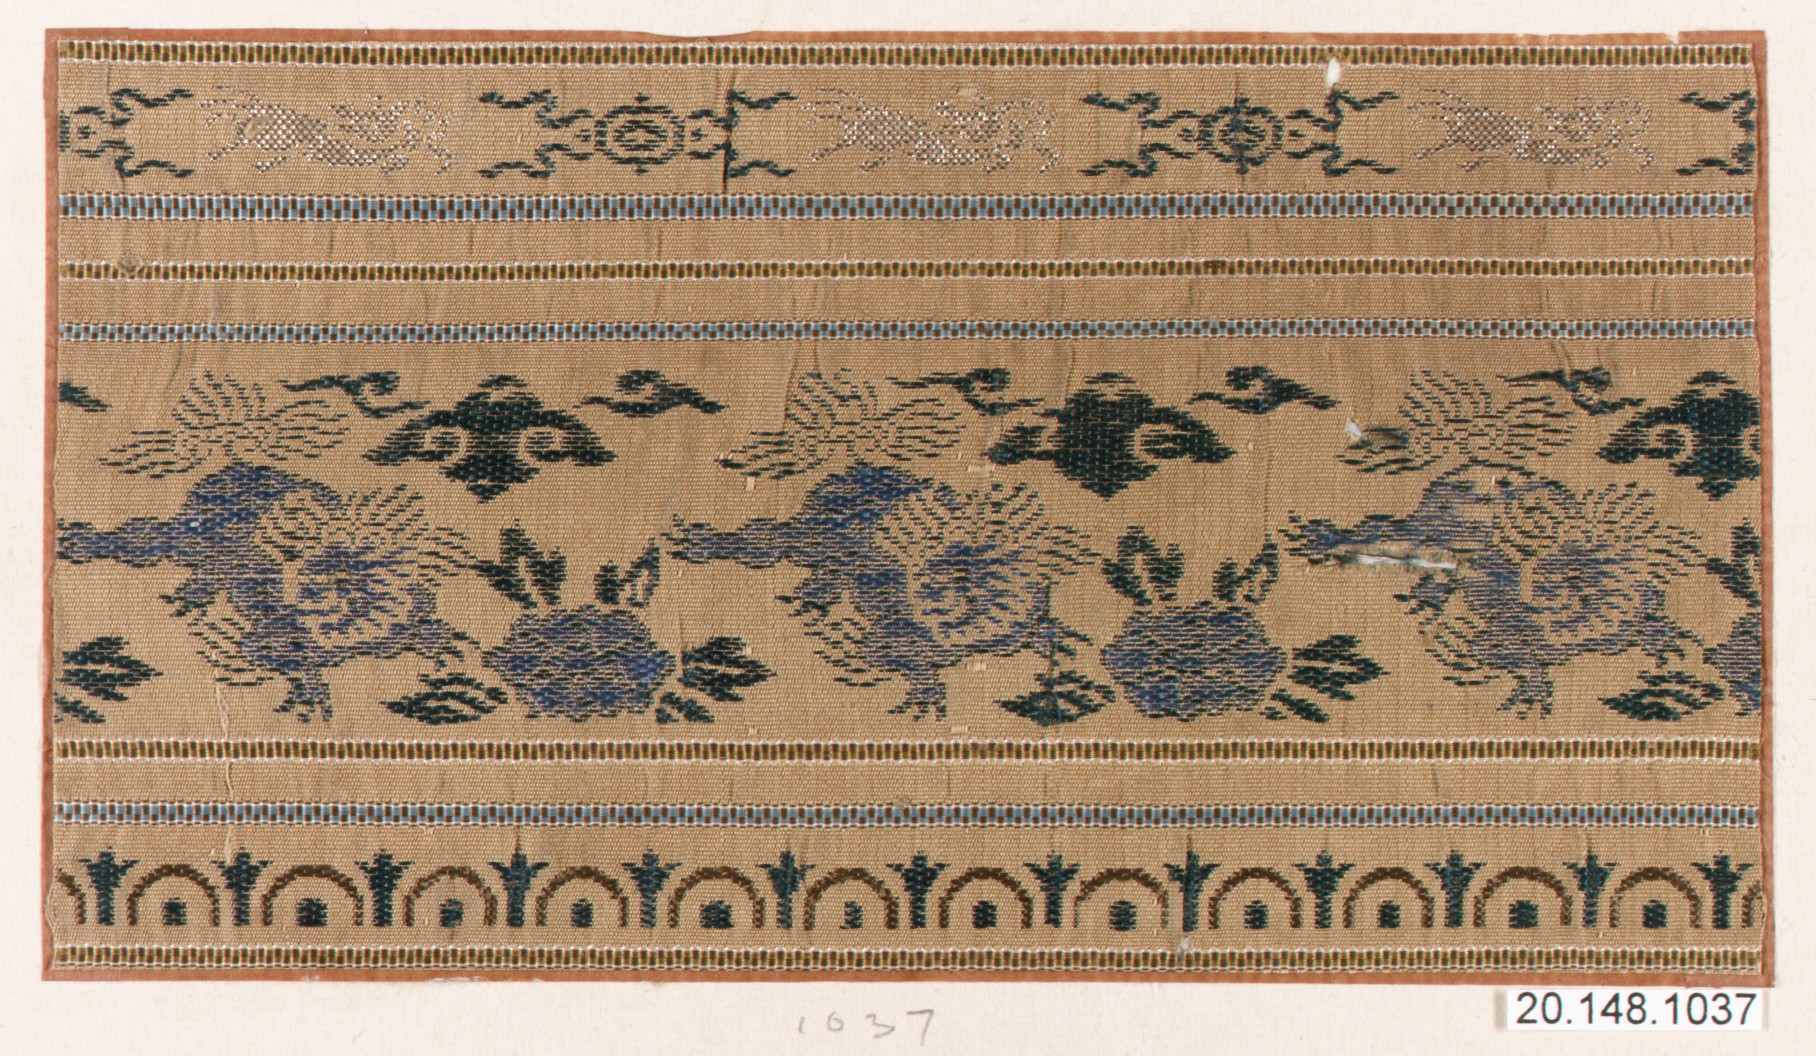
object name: piece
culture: japanese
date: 1701-1800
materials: silk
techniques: compound weave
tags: flowers